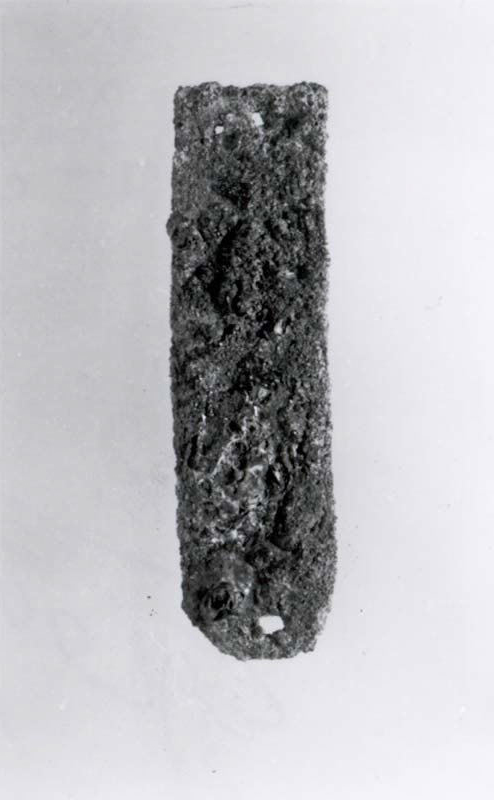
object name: armor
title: Armor plate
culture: assyrian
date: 734-601 BCE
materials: iron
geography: mesopotamia